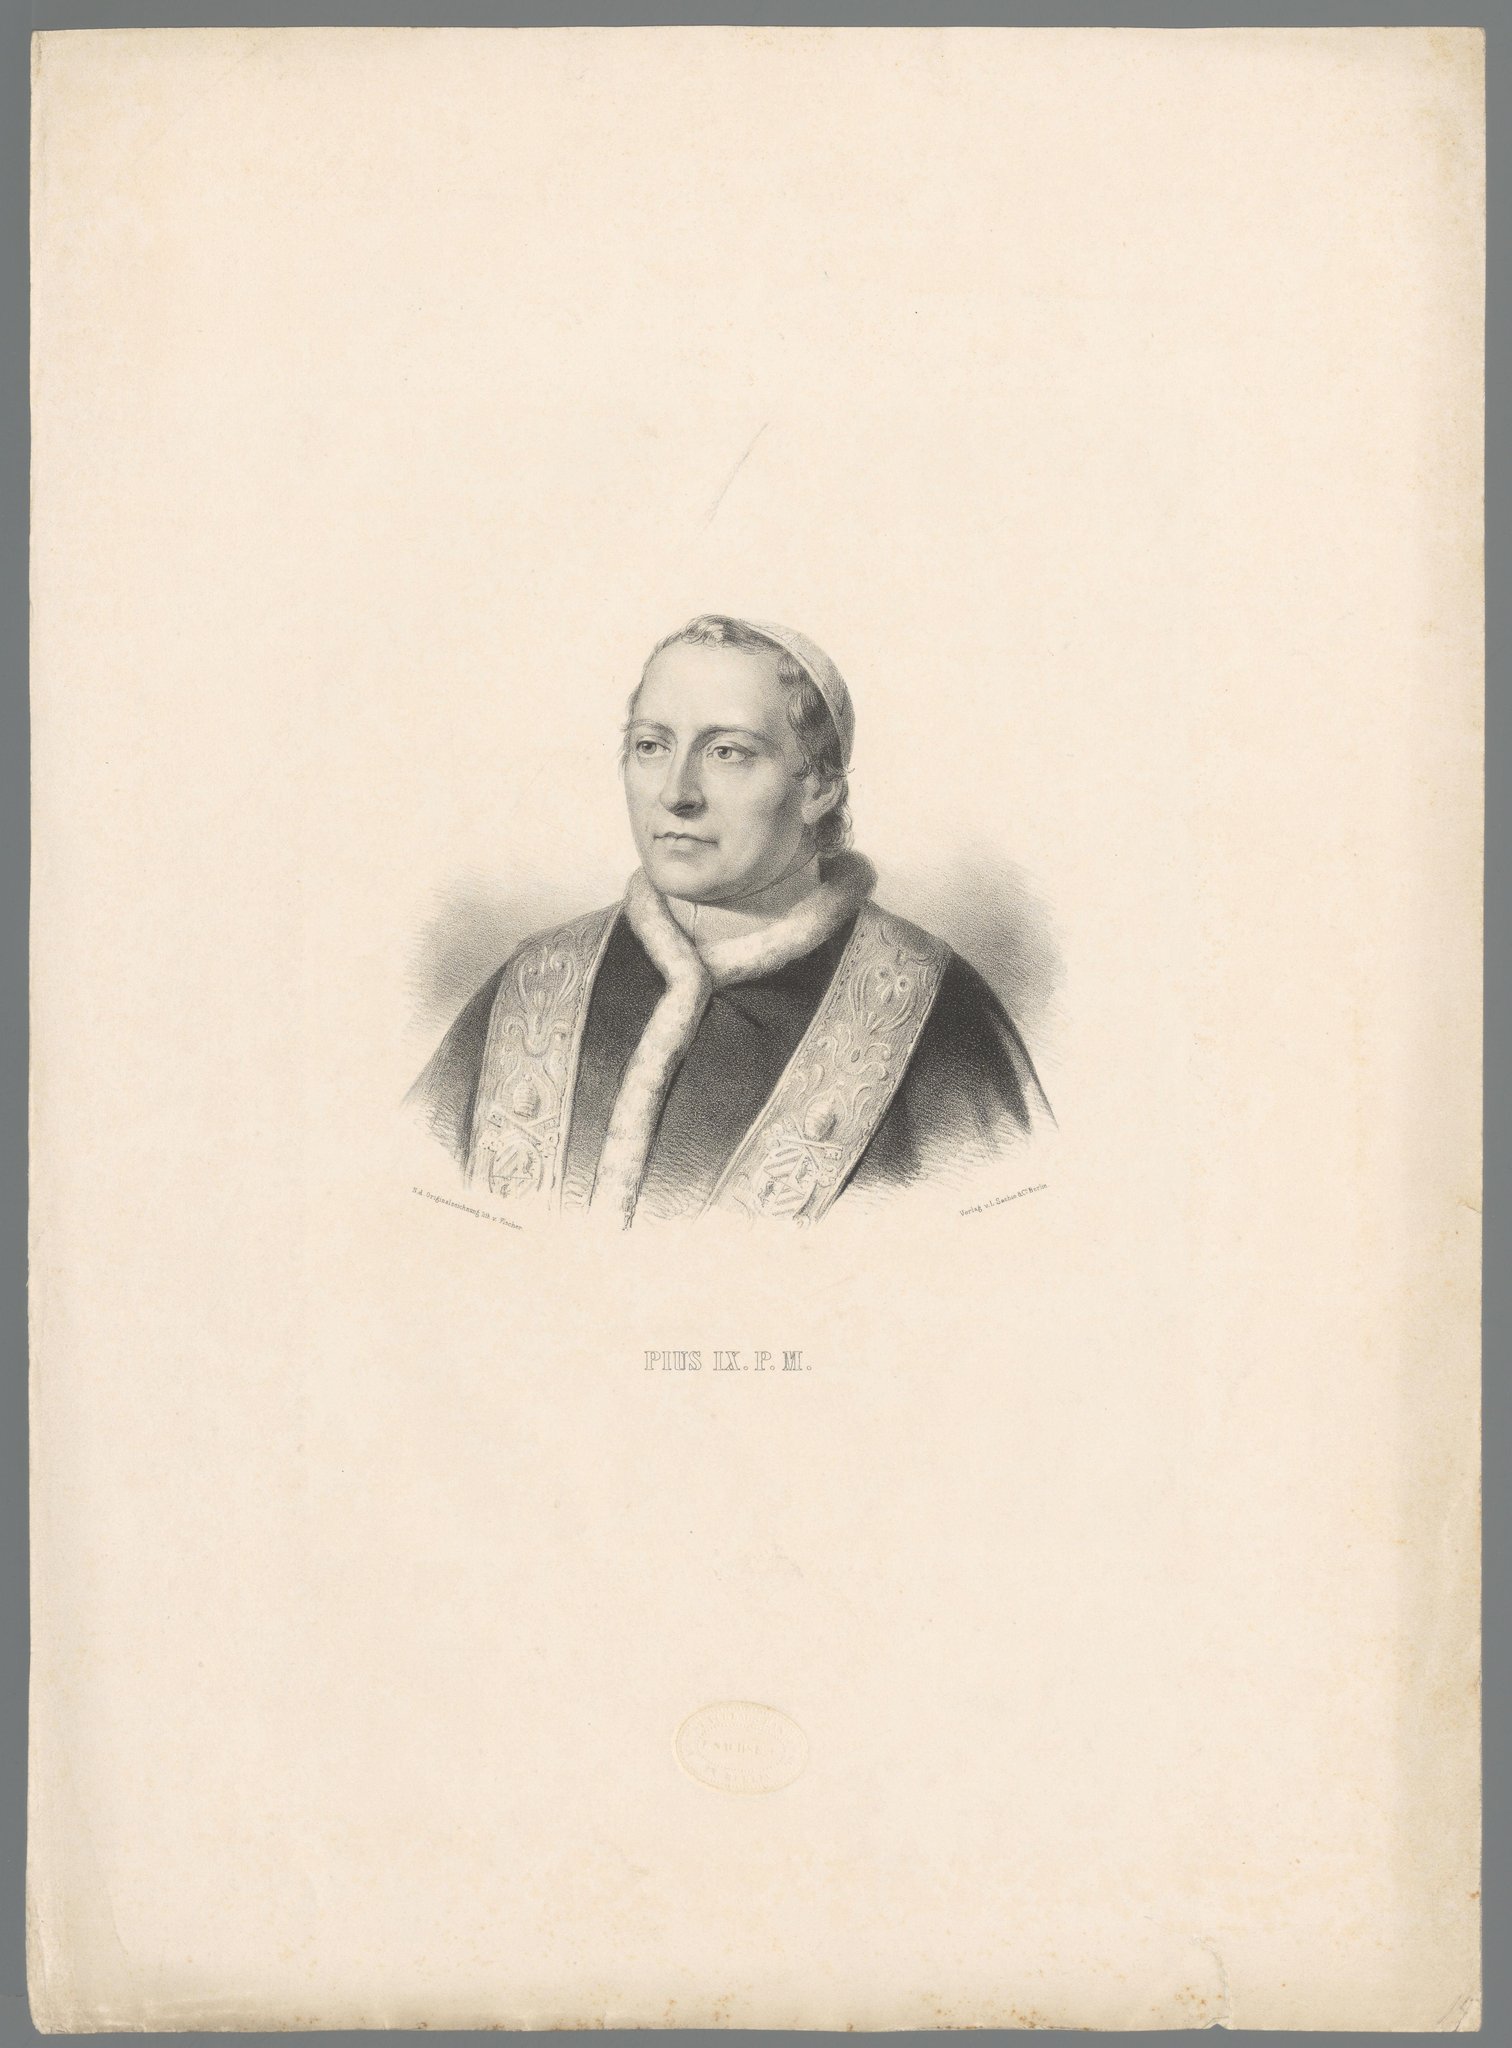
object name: print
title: Portret van Pius IX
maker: c. fischer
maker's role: print maker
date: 1832-1854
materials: paper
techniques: lithograph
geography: berlin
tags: rome, historical persons, pope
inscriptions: check stamp: Lugt 5005, collector's mark: Lugt 2228